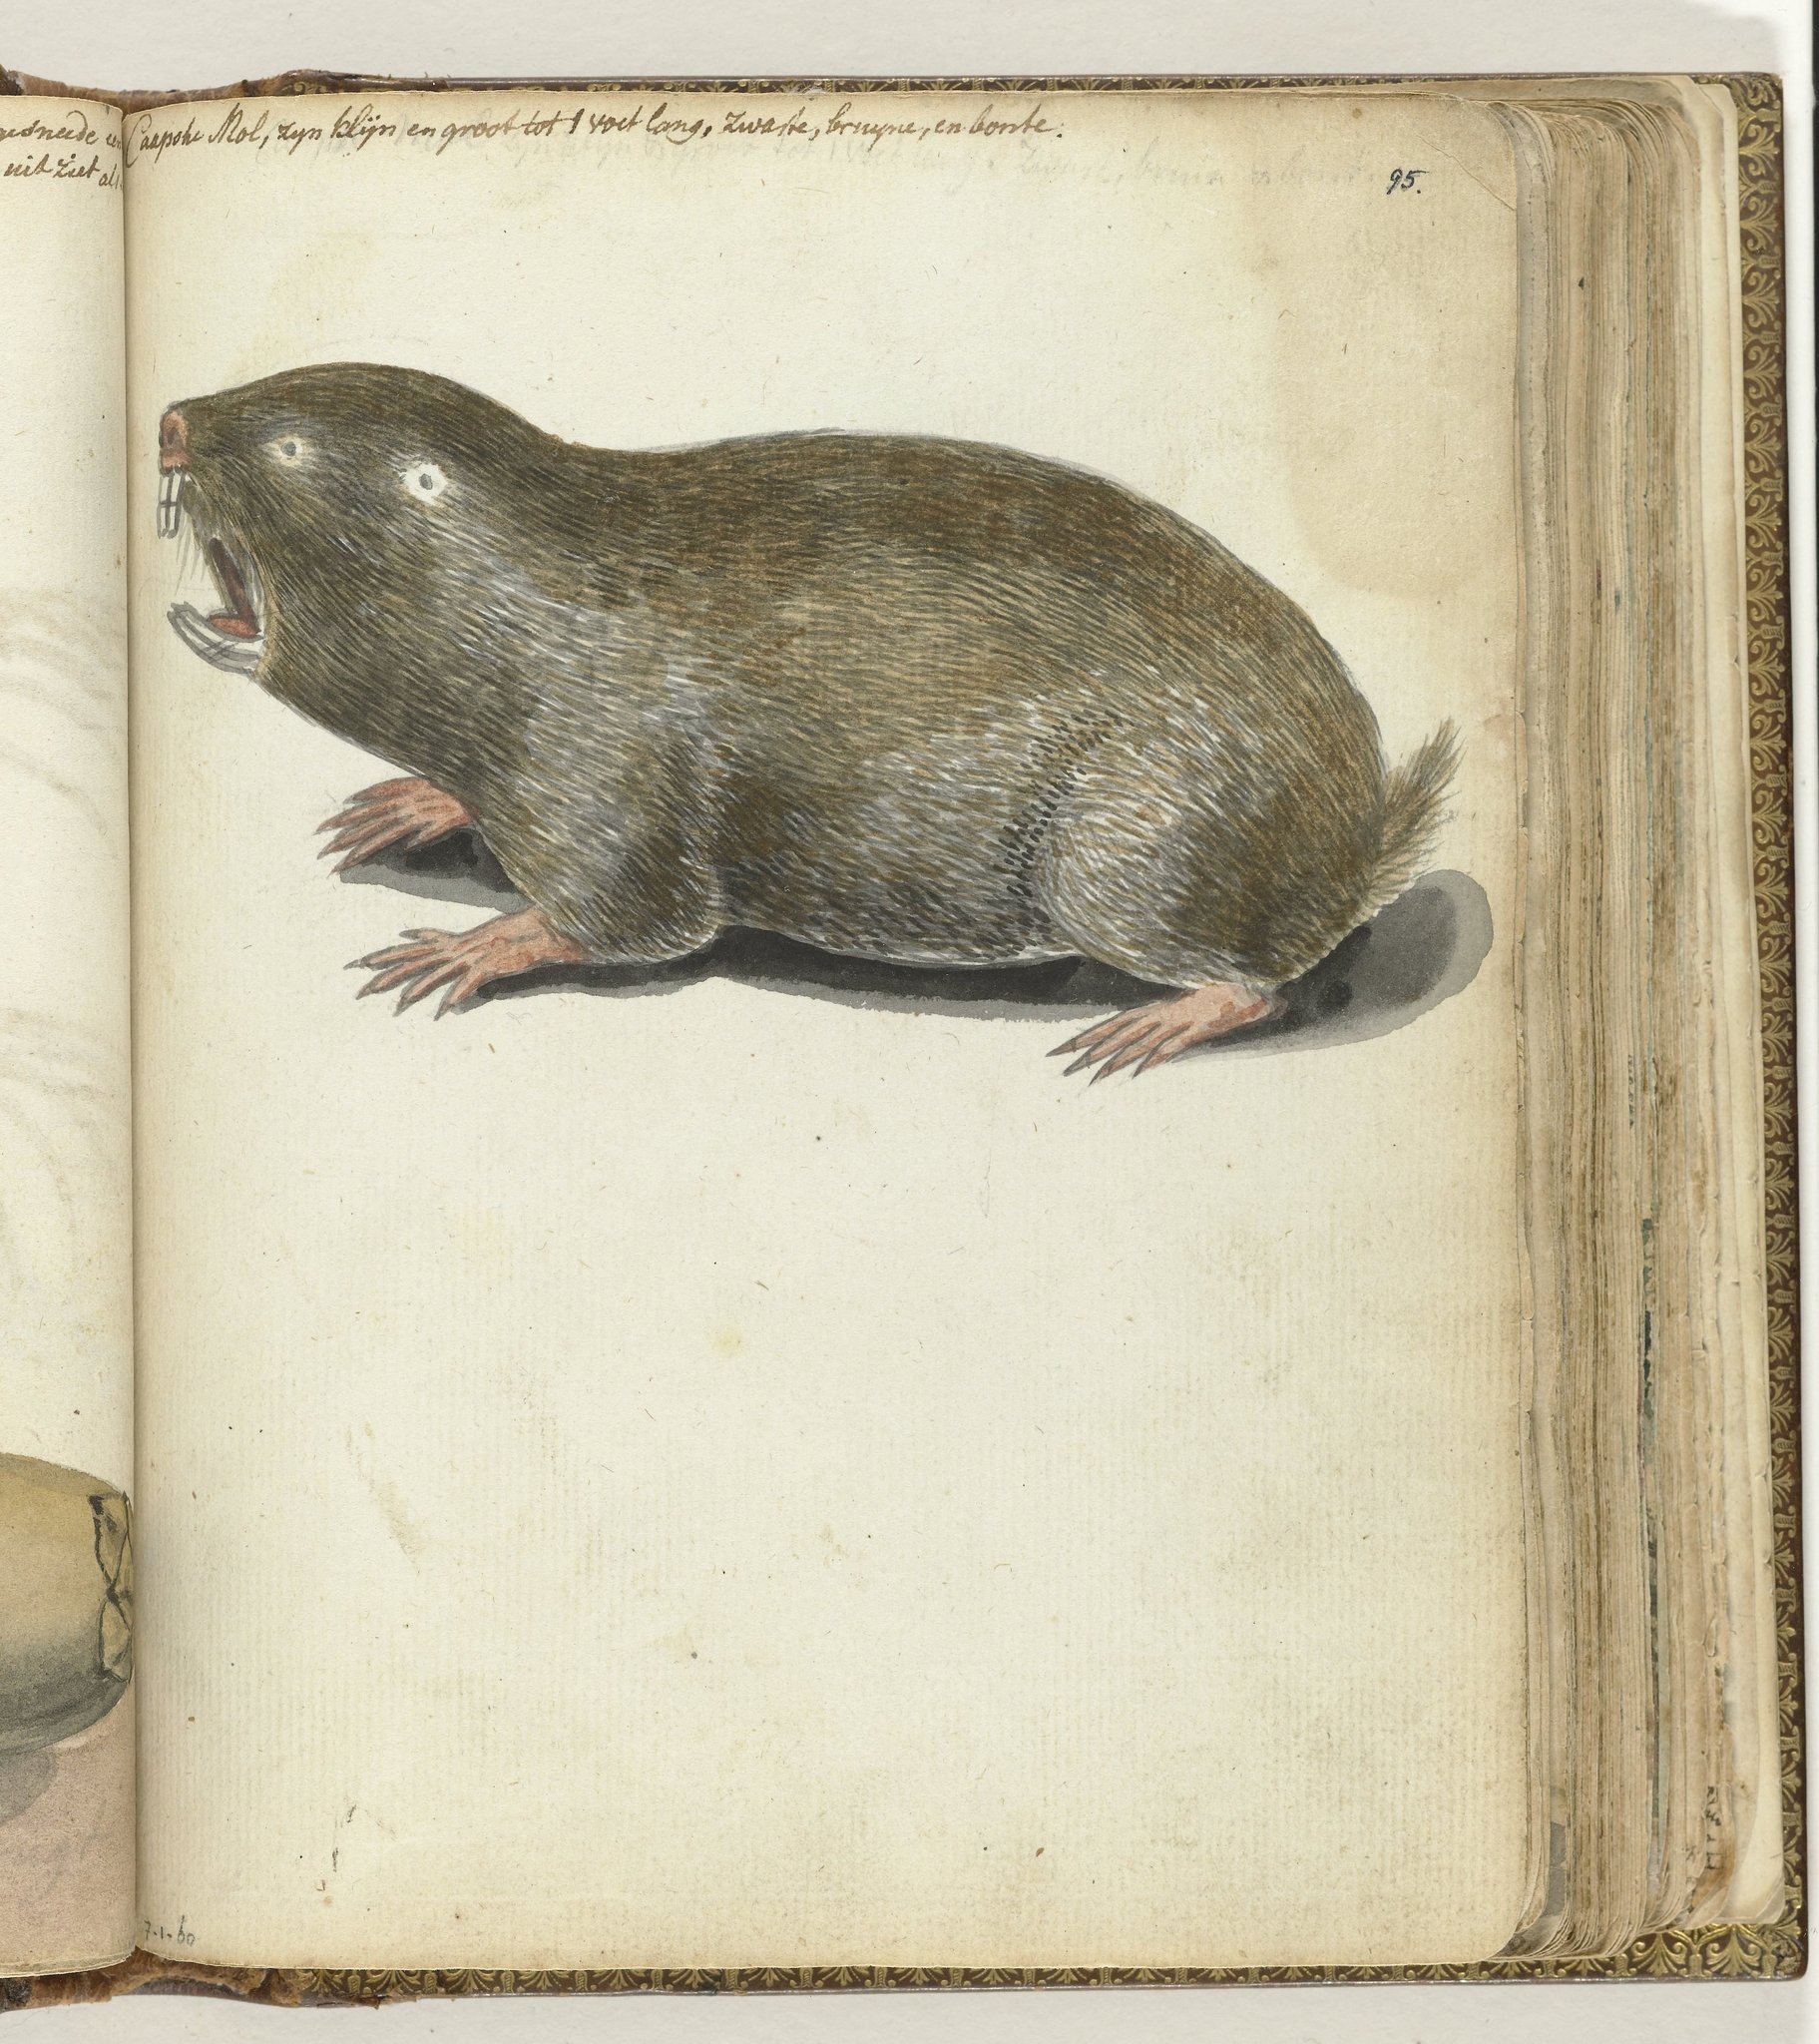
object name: drawing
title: Kaapse mol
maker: jan brandes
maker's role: draughtsman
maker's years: 1743-1808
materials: paper, pencil, watercolor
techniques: brush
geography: cape town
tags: other mammals: mole, cape of good hope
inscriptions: inscription: ‘Caapsche Mol, zyn klijn en groot tot 1 voet lang, zwarte, bruyne, en bonte.’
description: KLeurtekening van een mol met opengesperde bek die voorkomt op Kaap de Goede Hoop. Met opschrift. Onderdeel uit het schetsboek van Jan Brandes, dl. 1 (1808), p. 95.